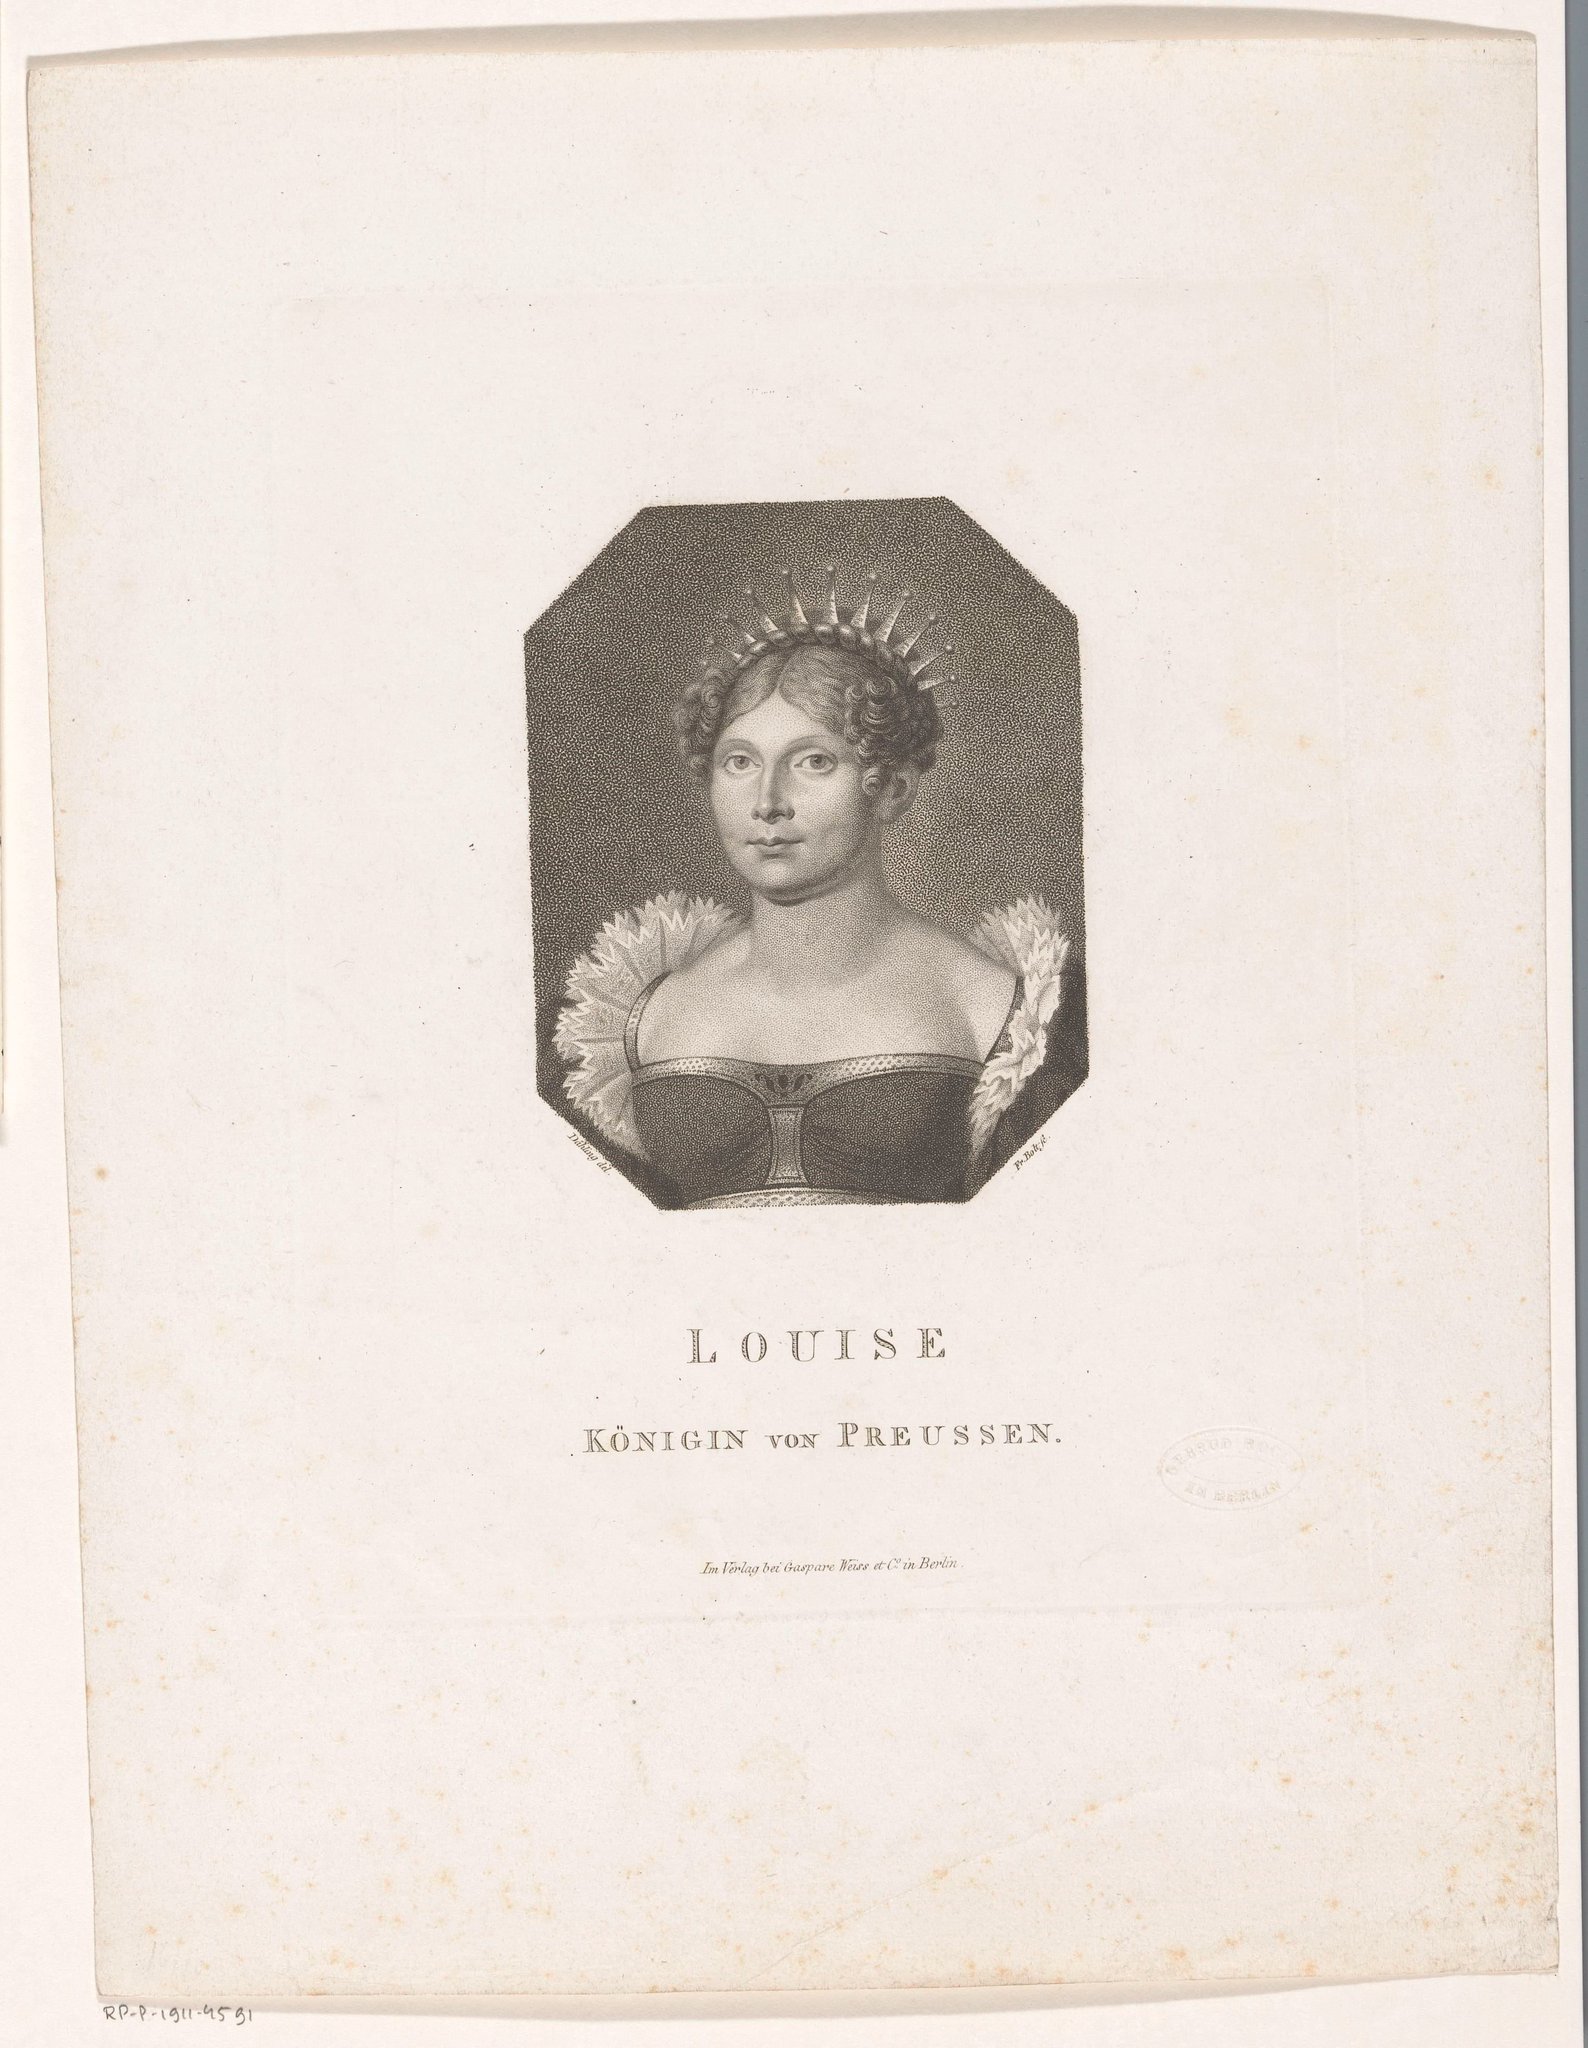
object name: print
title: Portret van Luise von Mecklenburg-Strelitz, koningin van Pruisen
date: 1797-1836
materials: paper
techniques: stippling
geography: berlin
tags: historical persons - bb - woman, diadem (symbol of sovereignty) - bb - female ruler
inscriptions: collector's mark: Lugt 2141c, collector's mark: Lugt 2228